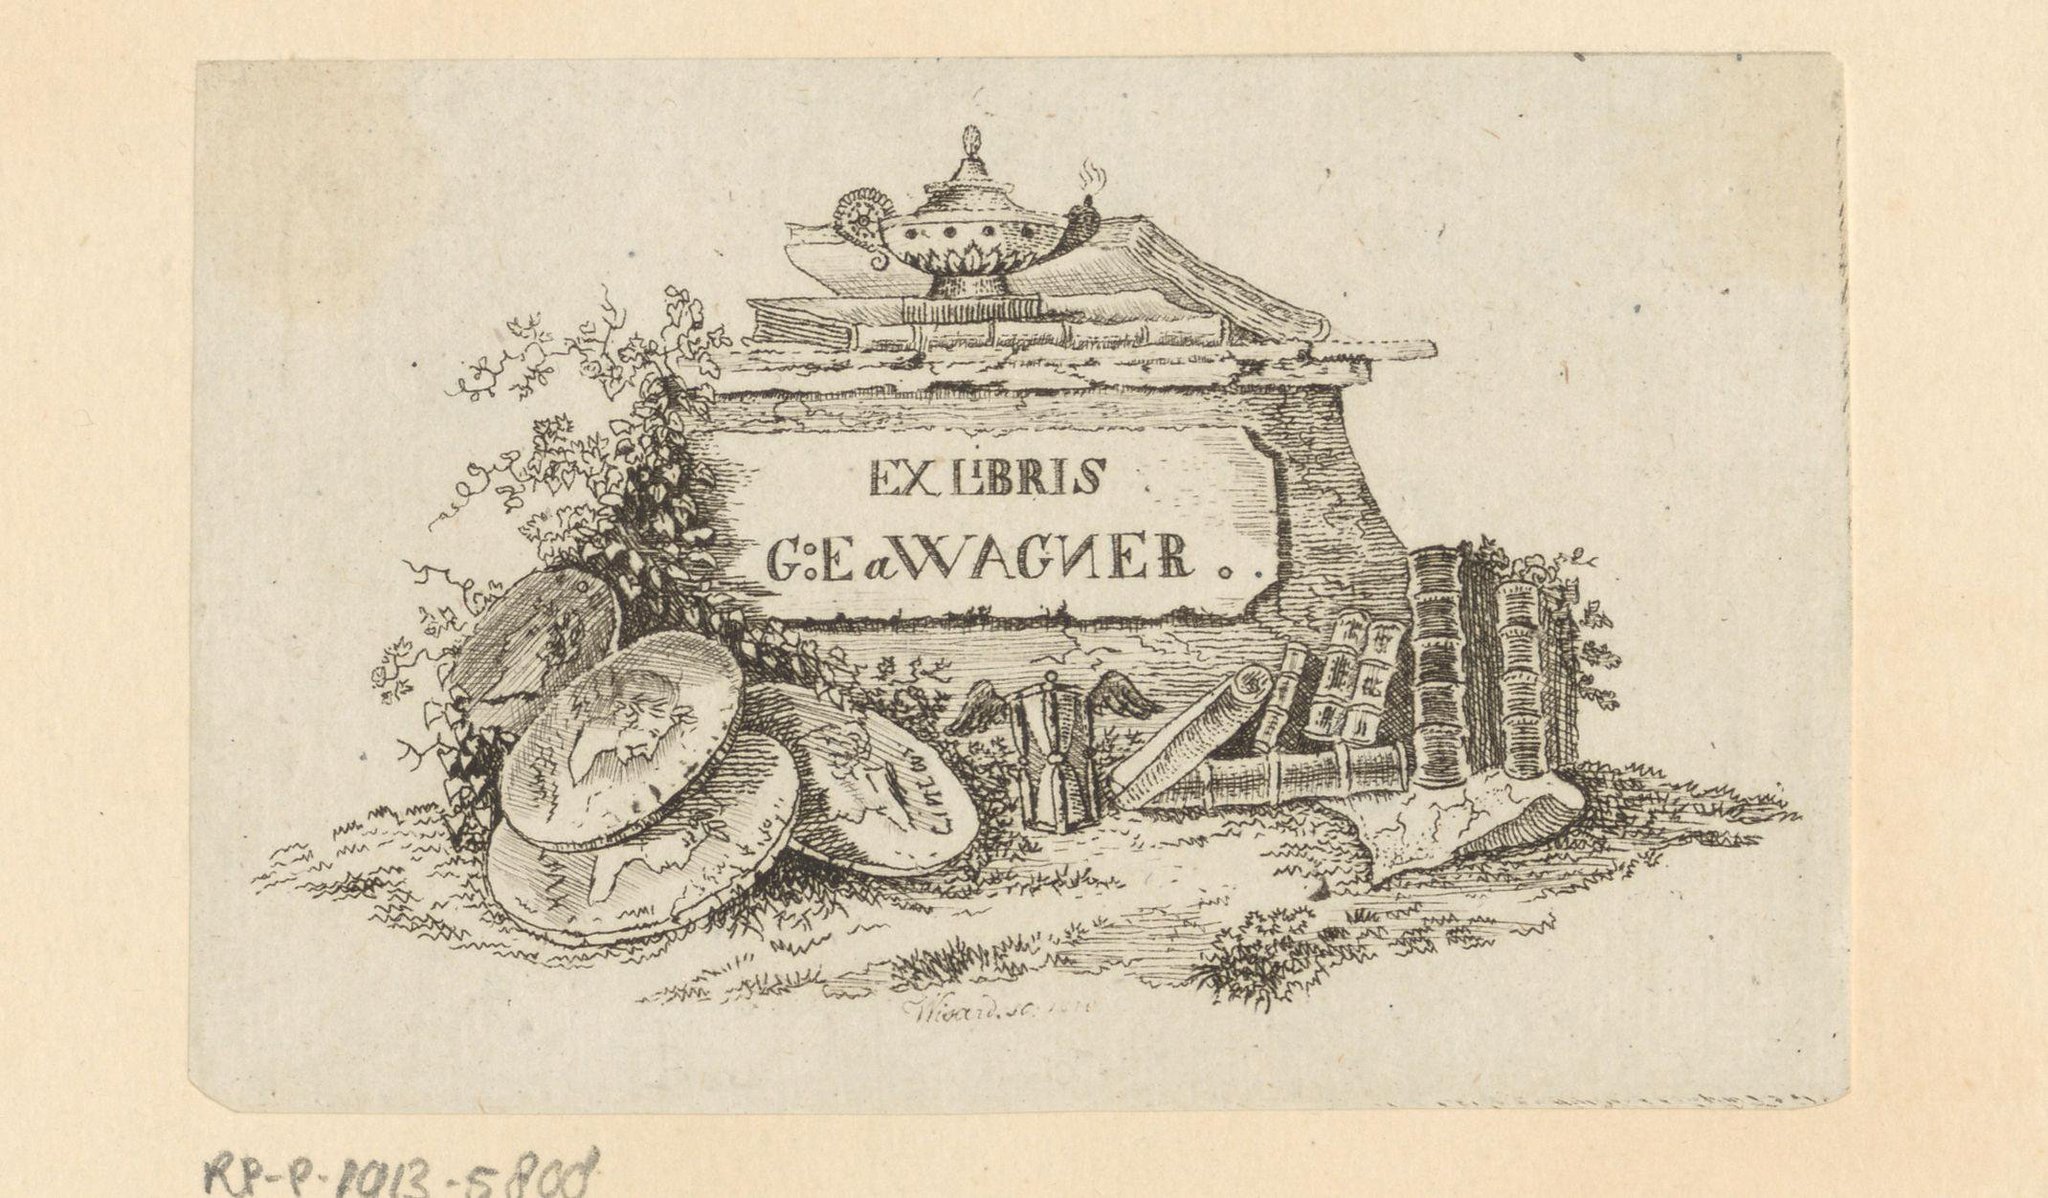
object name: bookplate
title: Ex libris van G.E. a Wagner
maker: gottlieb emanuel wysard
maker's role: painter, print maker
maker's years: 1787-1837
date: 1818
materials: paper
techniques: etching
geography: switzerland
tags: book, hourglass, oil-lamp, coin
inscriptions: inscription: ‘Gerster 2430’, collector's mark: Lugt 2233, collector's mark: Lugt 2760